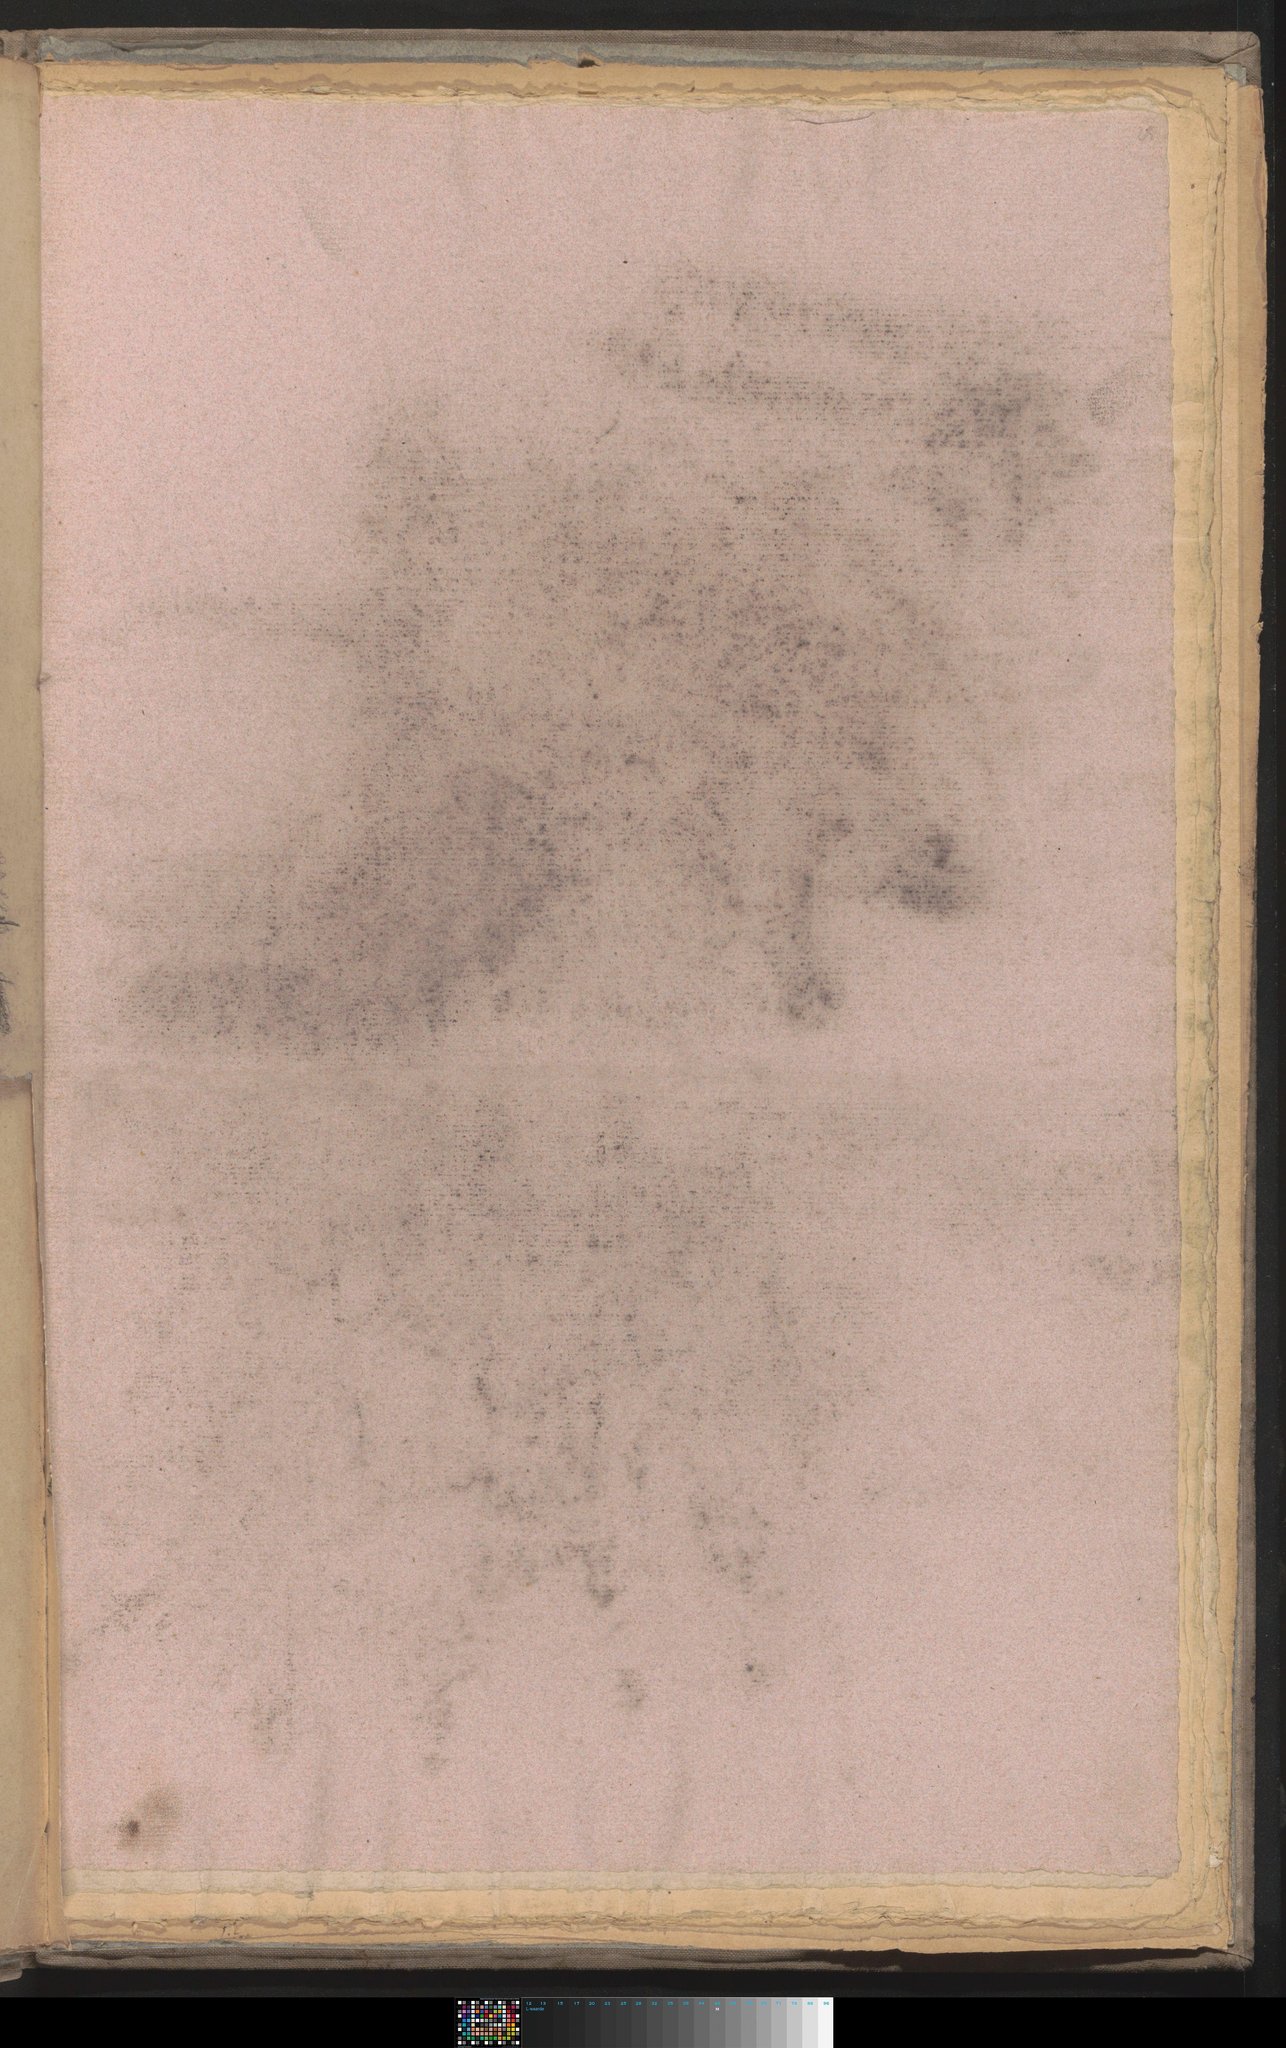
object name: sketchbook leaf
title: Abklatsch van de krijttekening op pagina 24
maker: willem witsen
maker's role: draughtsman, painter, print maker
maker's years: 1860-1923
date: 1886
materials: paper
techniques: printmaking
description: Pagina 25 uit een schetsboek met 38 bladen betekend rond de Ewijkshoeve.